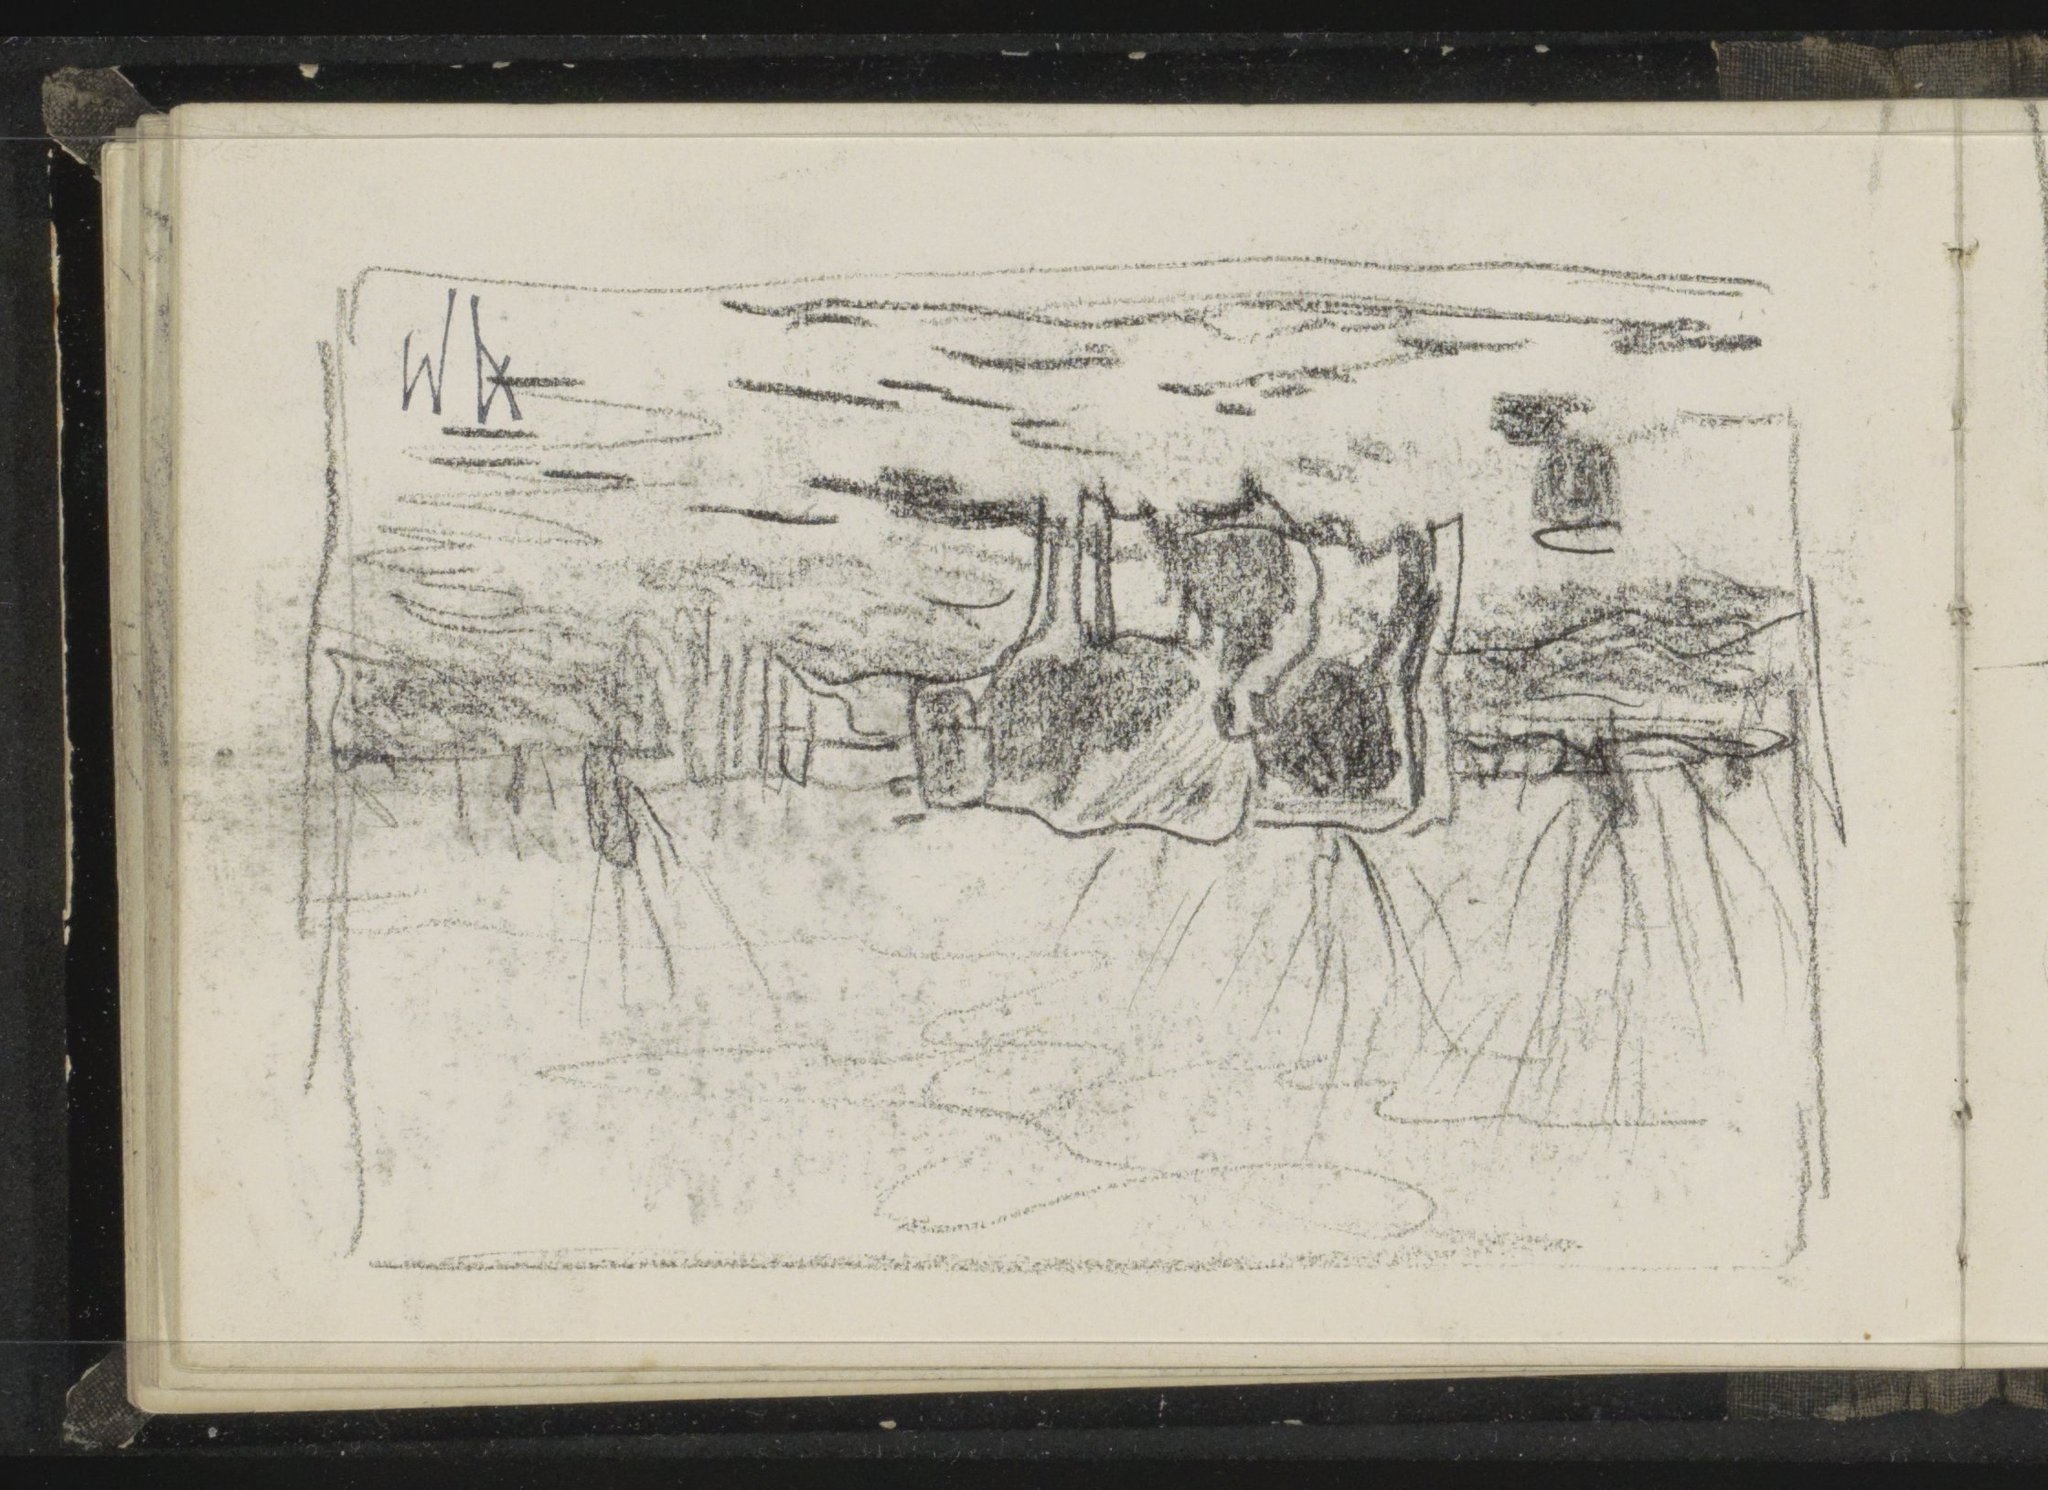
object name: sketchbook leaf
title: Figuur die een koe melkt in een weide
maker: anton mauve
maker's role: draughtsman, painter, print maker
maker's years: 1838-1888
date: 1848-1888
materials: chalk, paper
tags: cow, milking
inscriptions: monogram: ‘AM’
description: Op de achtergrond knotwilgen. Blad 17 verso uit een schetsboek met 33 bladen.